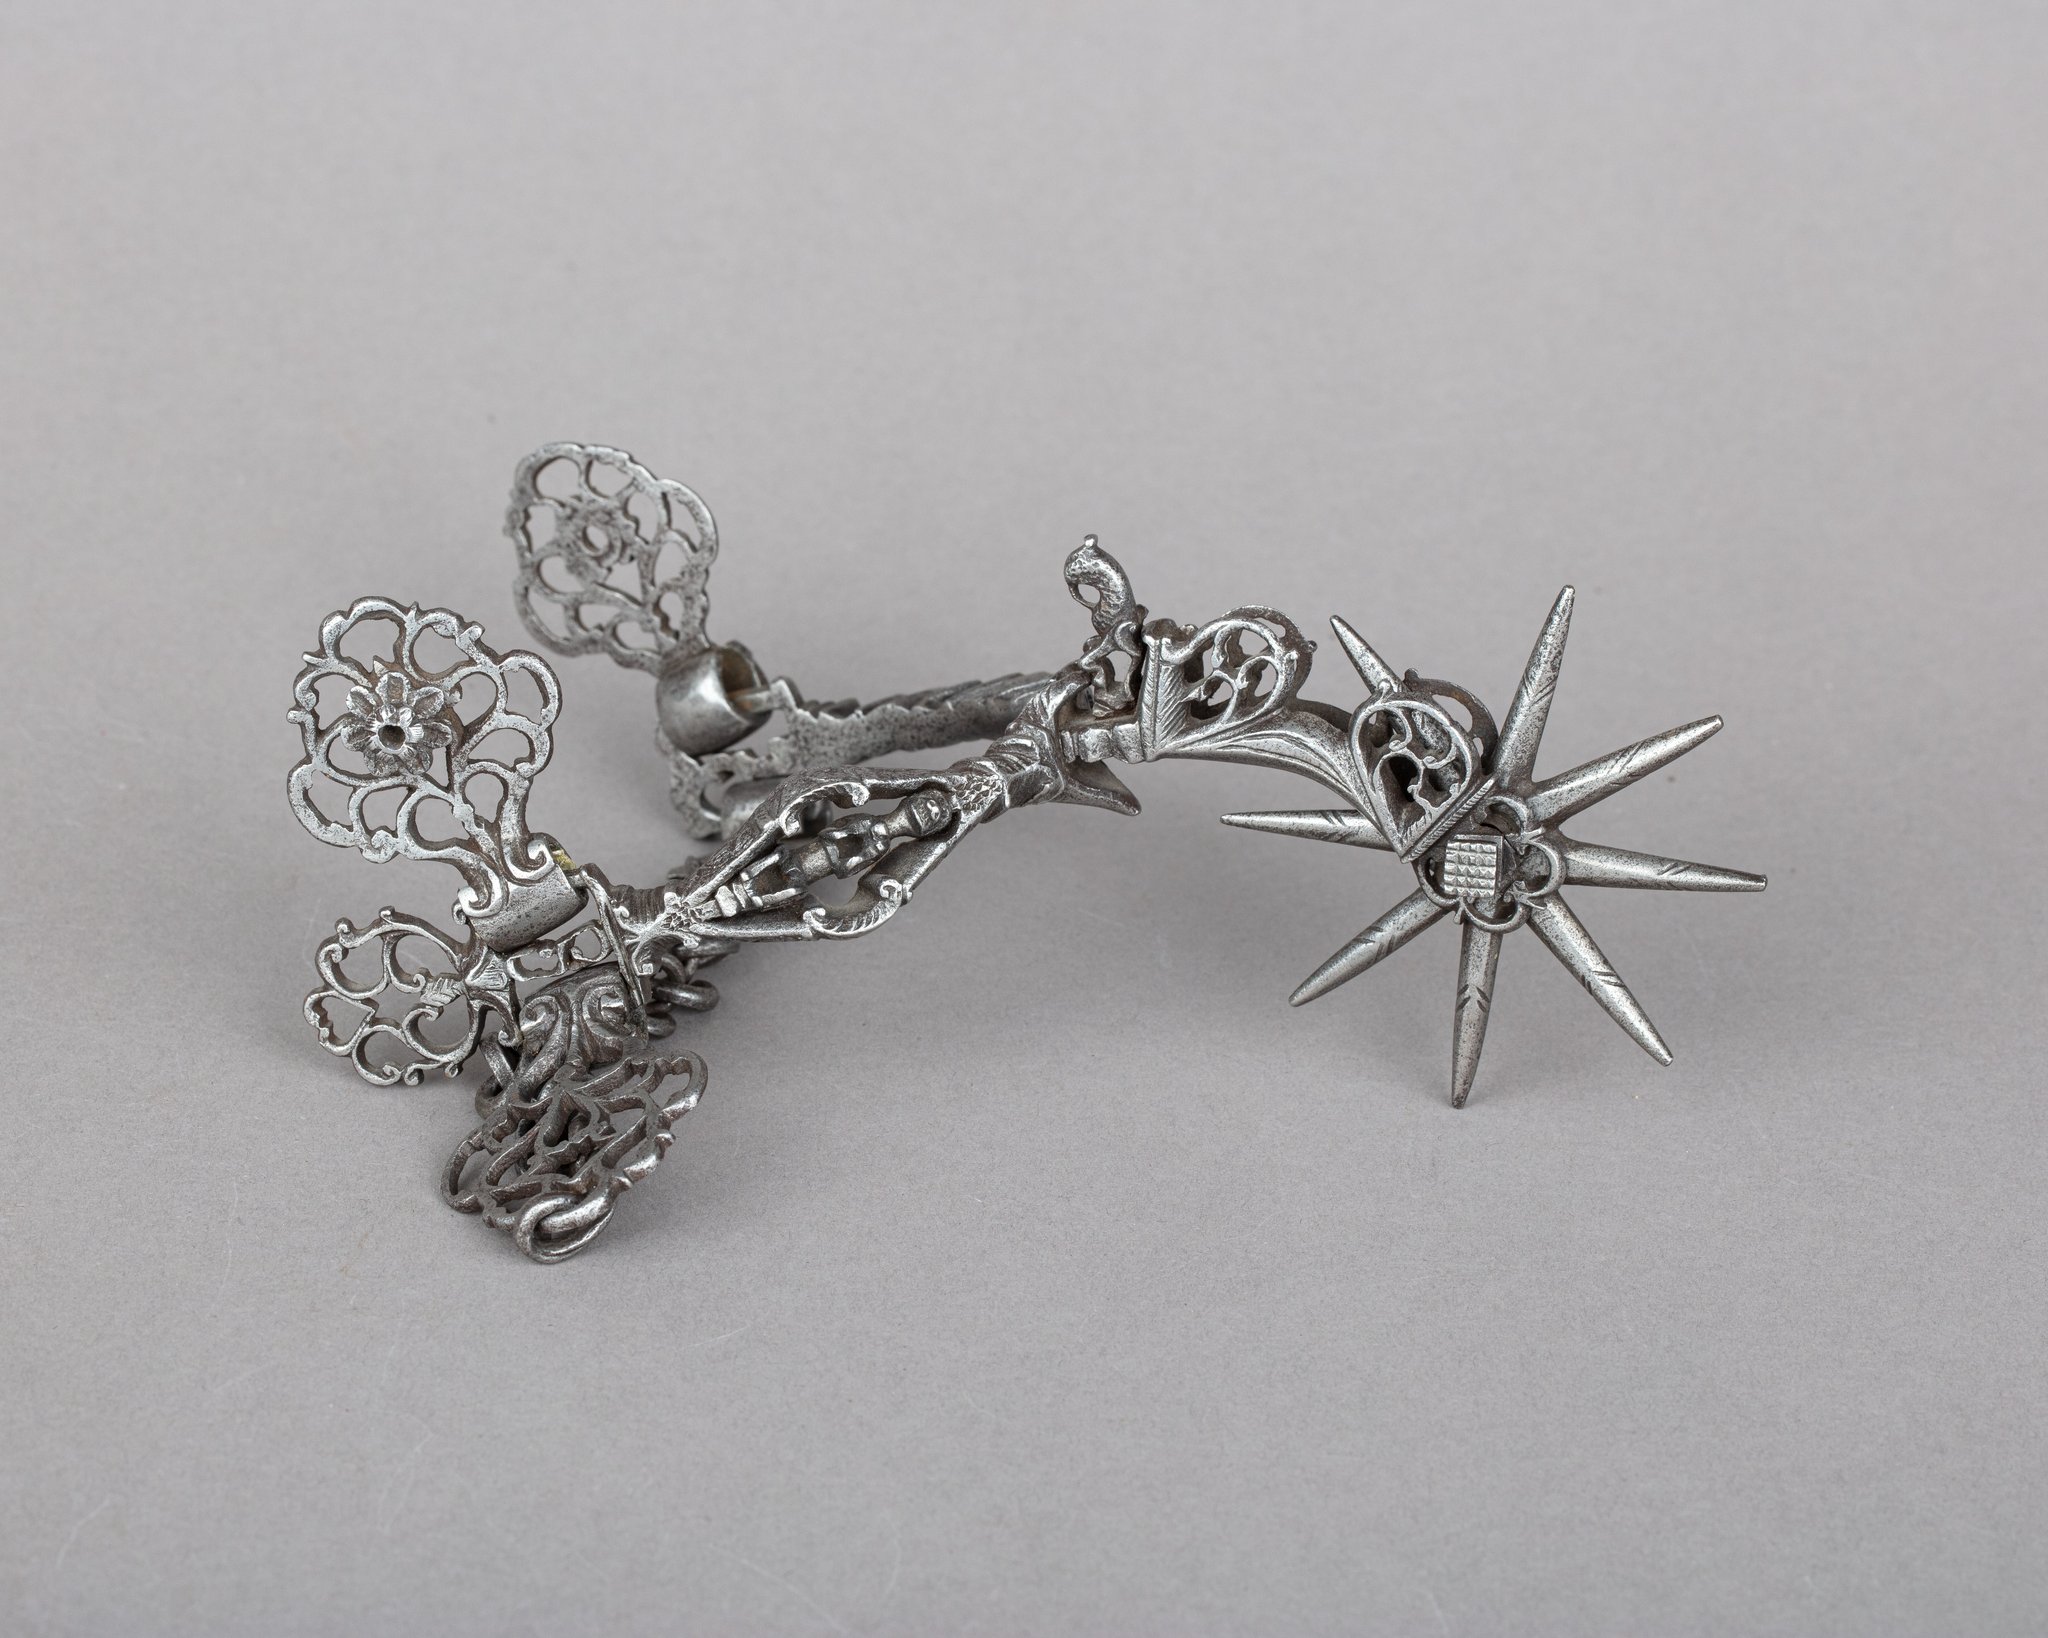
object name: spur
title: Rowel Spur (Left)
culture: mexican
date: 1701-1750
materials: metal alloy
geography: mexico